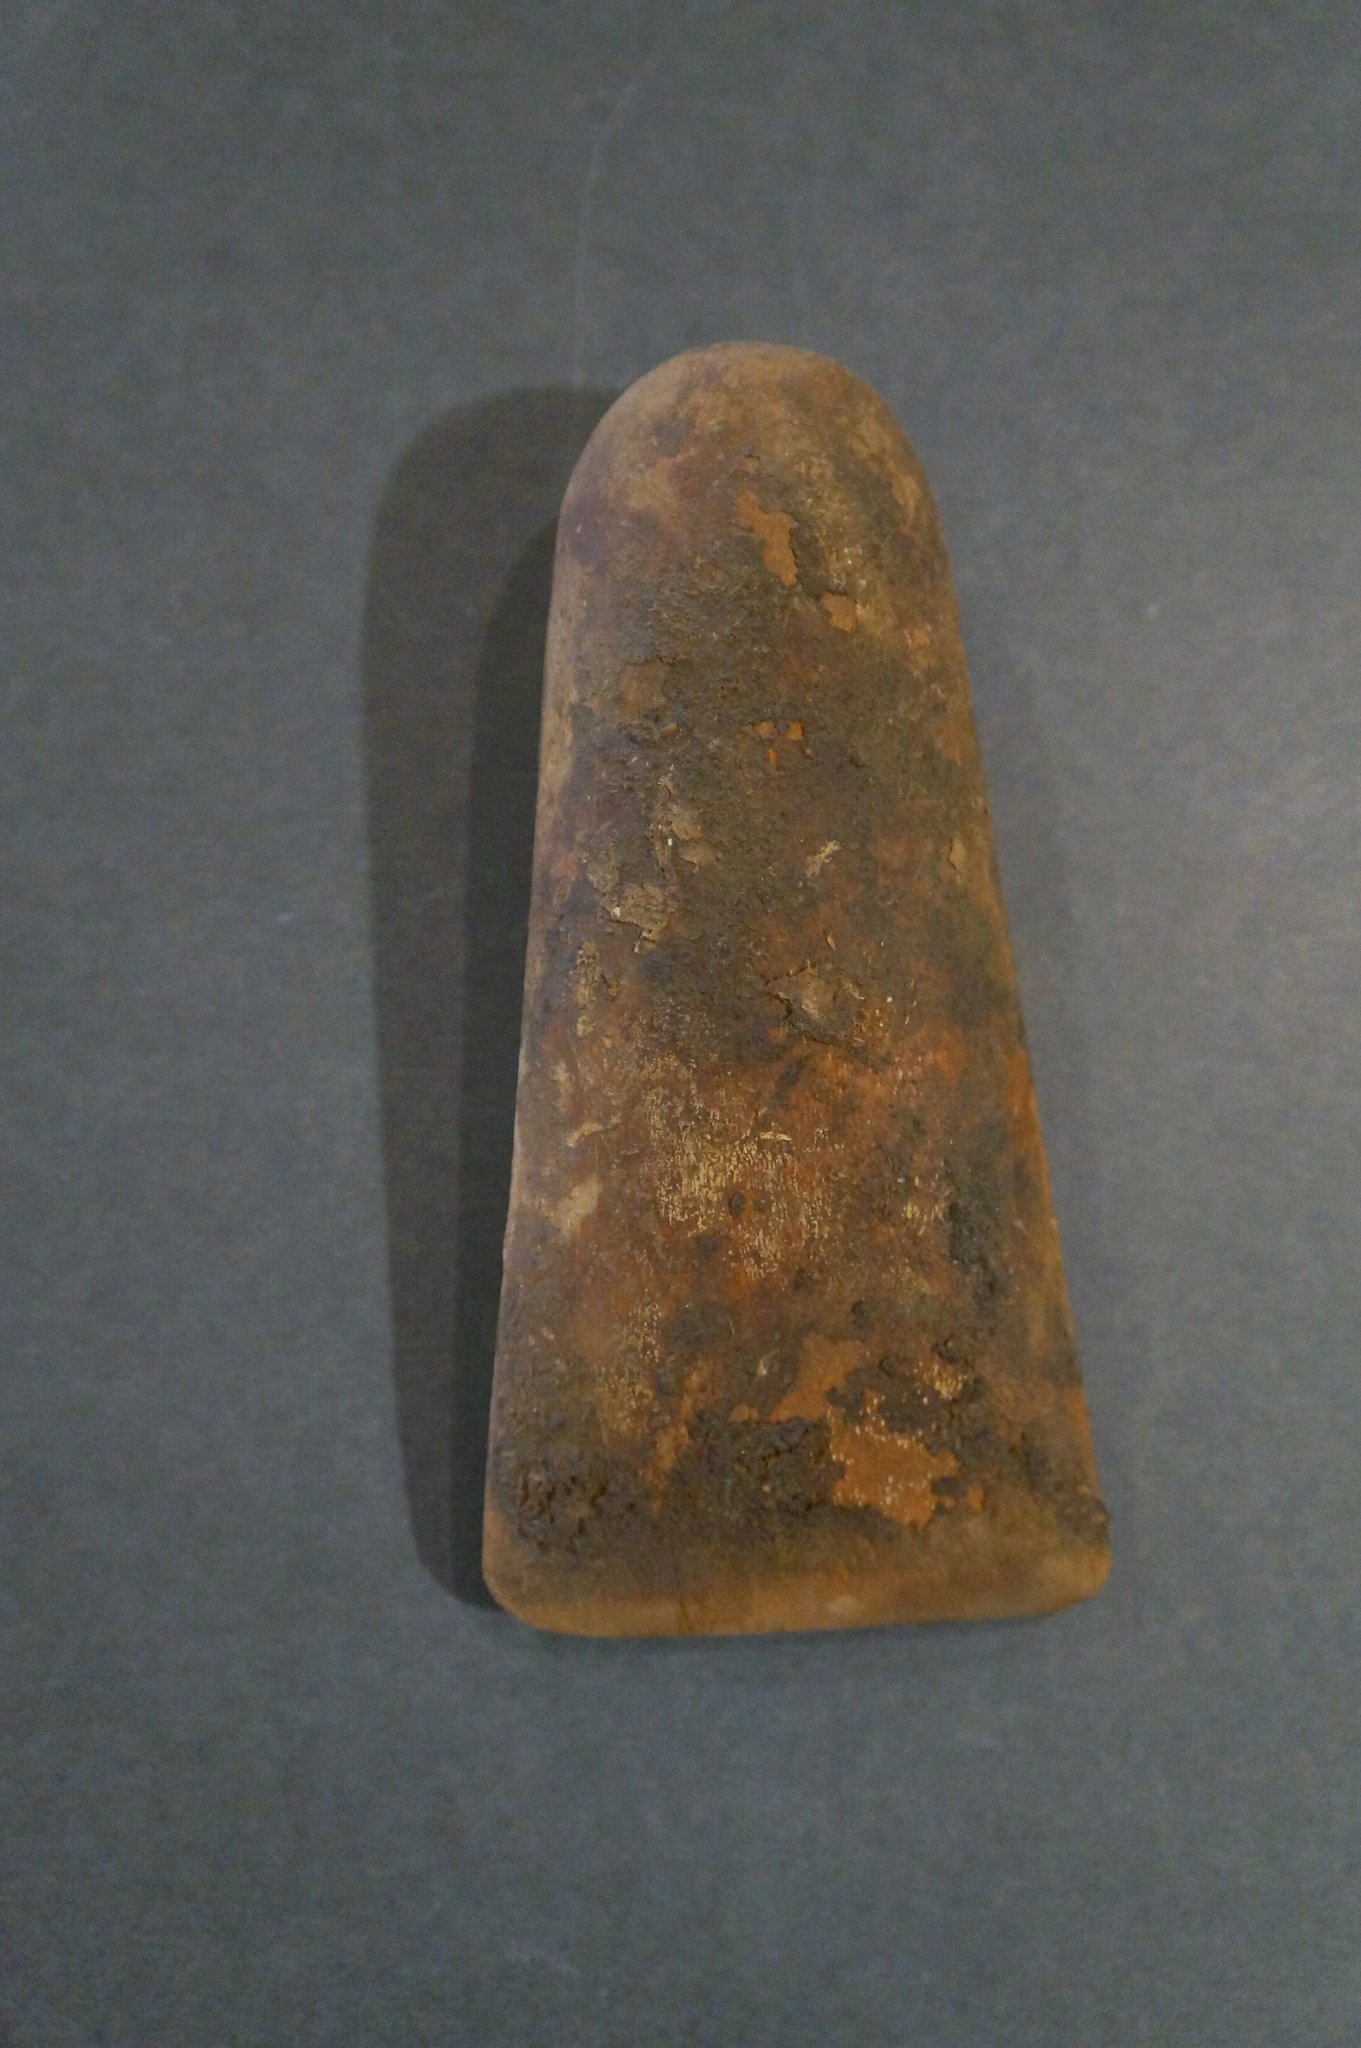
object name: tool, embalmer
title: Embalmer's Tool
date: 1580-1479 BCE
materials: wood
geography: egypt